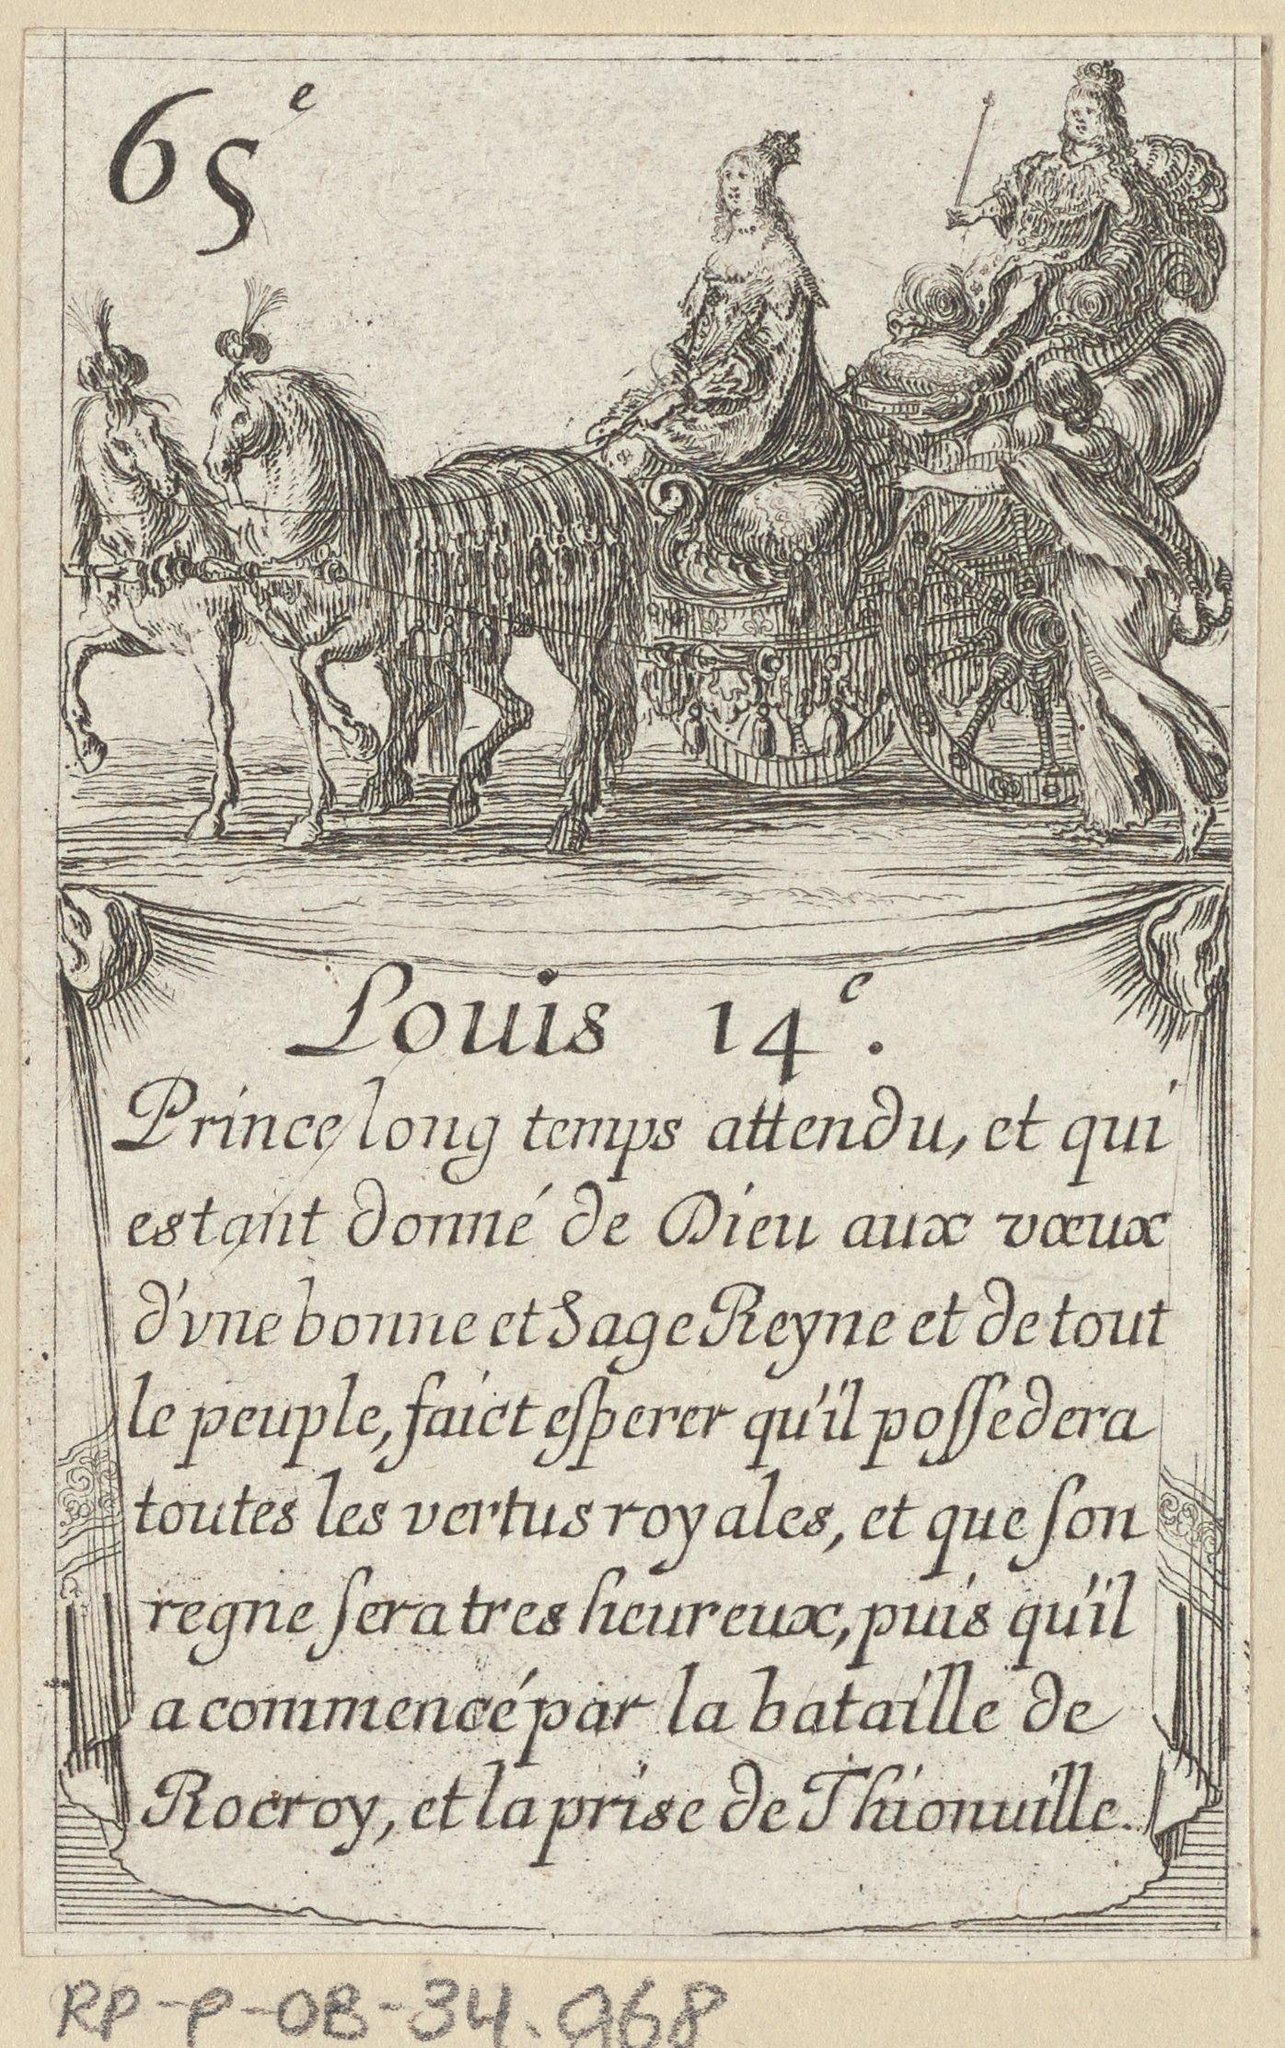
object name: print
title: Kaartspel met heersers van Frankrijk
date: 1620-1664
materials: paper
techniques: etching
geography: paris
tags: lodewijk xiv (koning van frankrijk), ruler, sovereign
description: Deze prent maakt deel uit van een kaartspel met 39 kaarten met voorstellingen van Franse koningen. De serie is uitgedacht door Jean Desmarests de Saint-Sorlin in opdracht van Kardinaal Mazarin. Het kaartspel werd gemaakt voor de jonge Lodewijk XIV, samen met het Jeu des Fables, Jeu des Reynes Renommées en Jeu de la géographie.